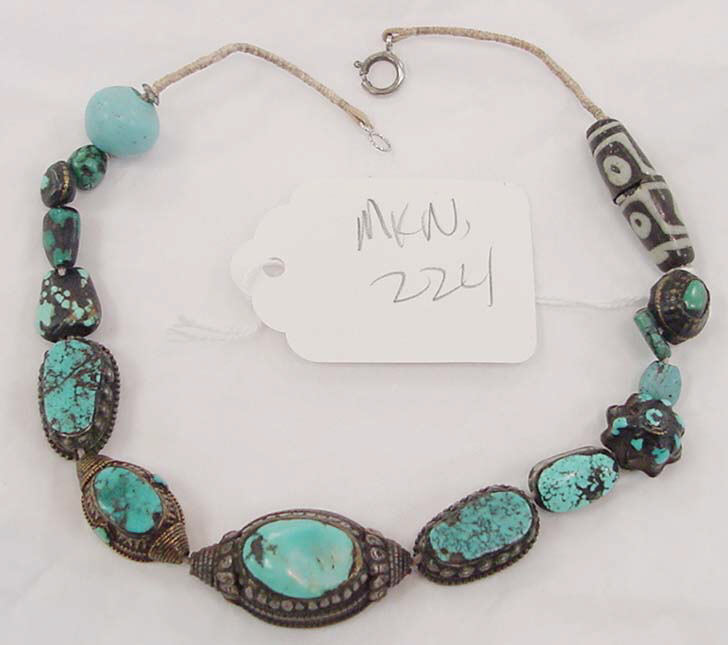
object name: necklace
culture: tibetan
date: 1701-1800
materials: cotton, glass, metal